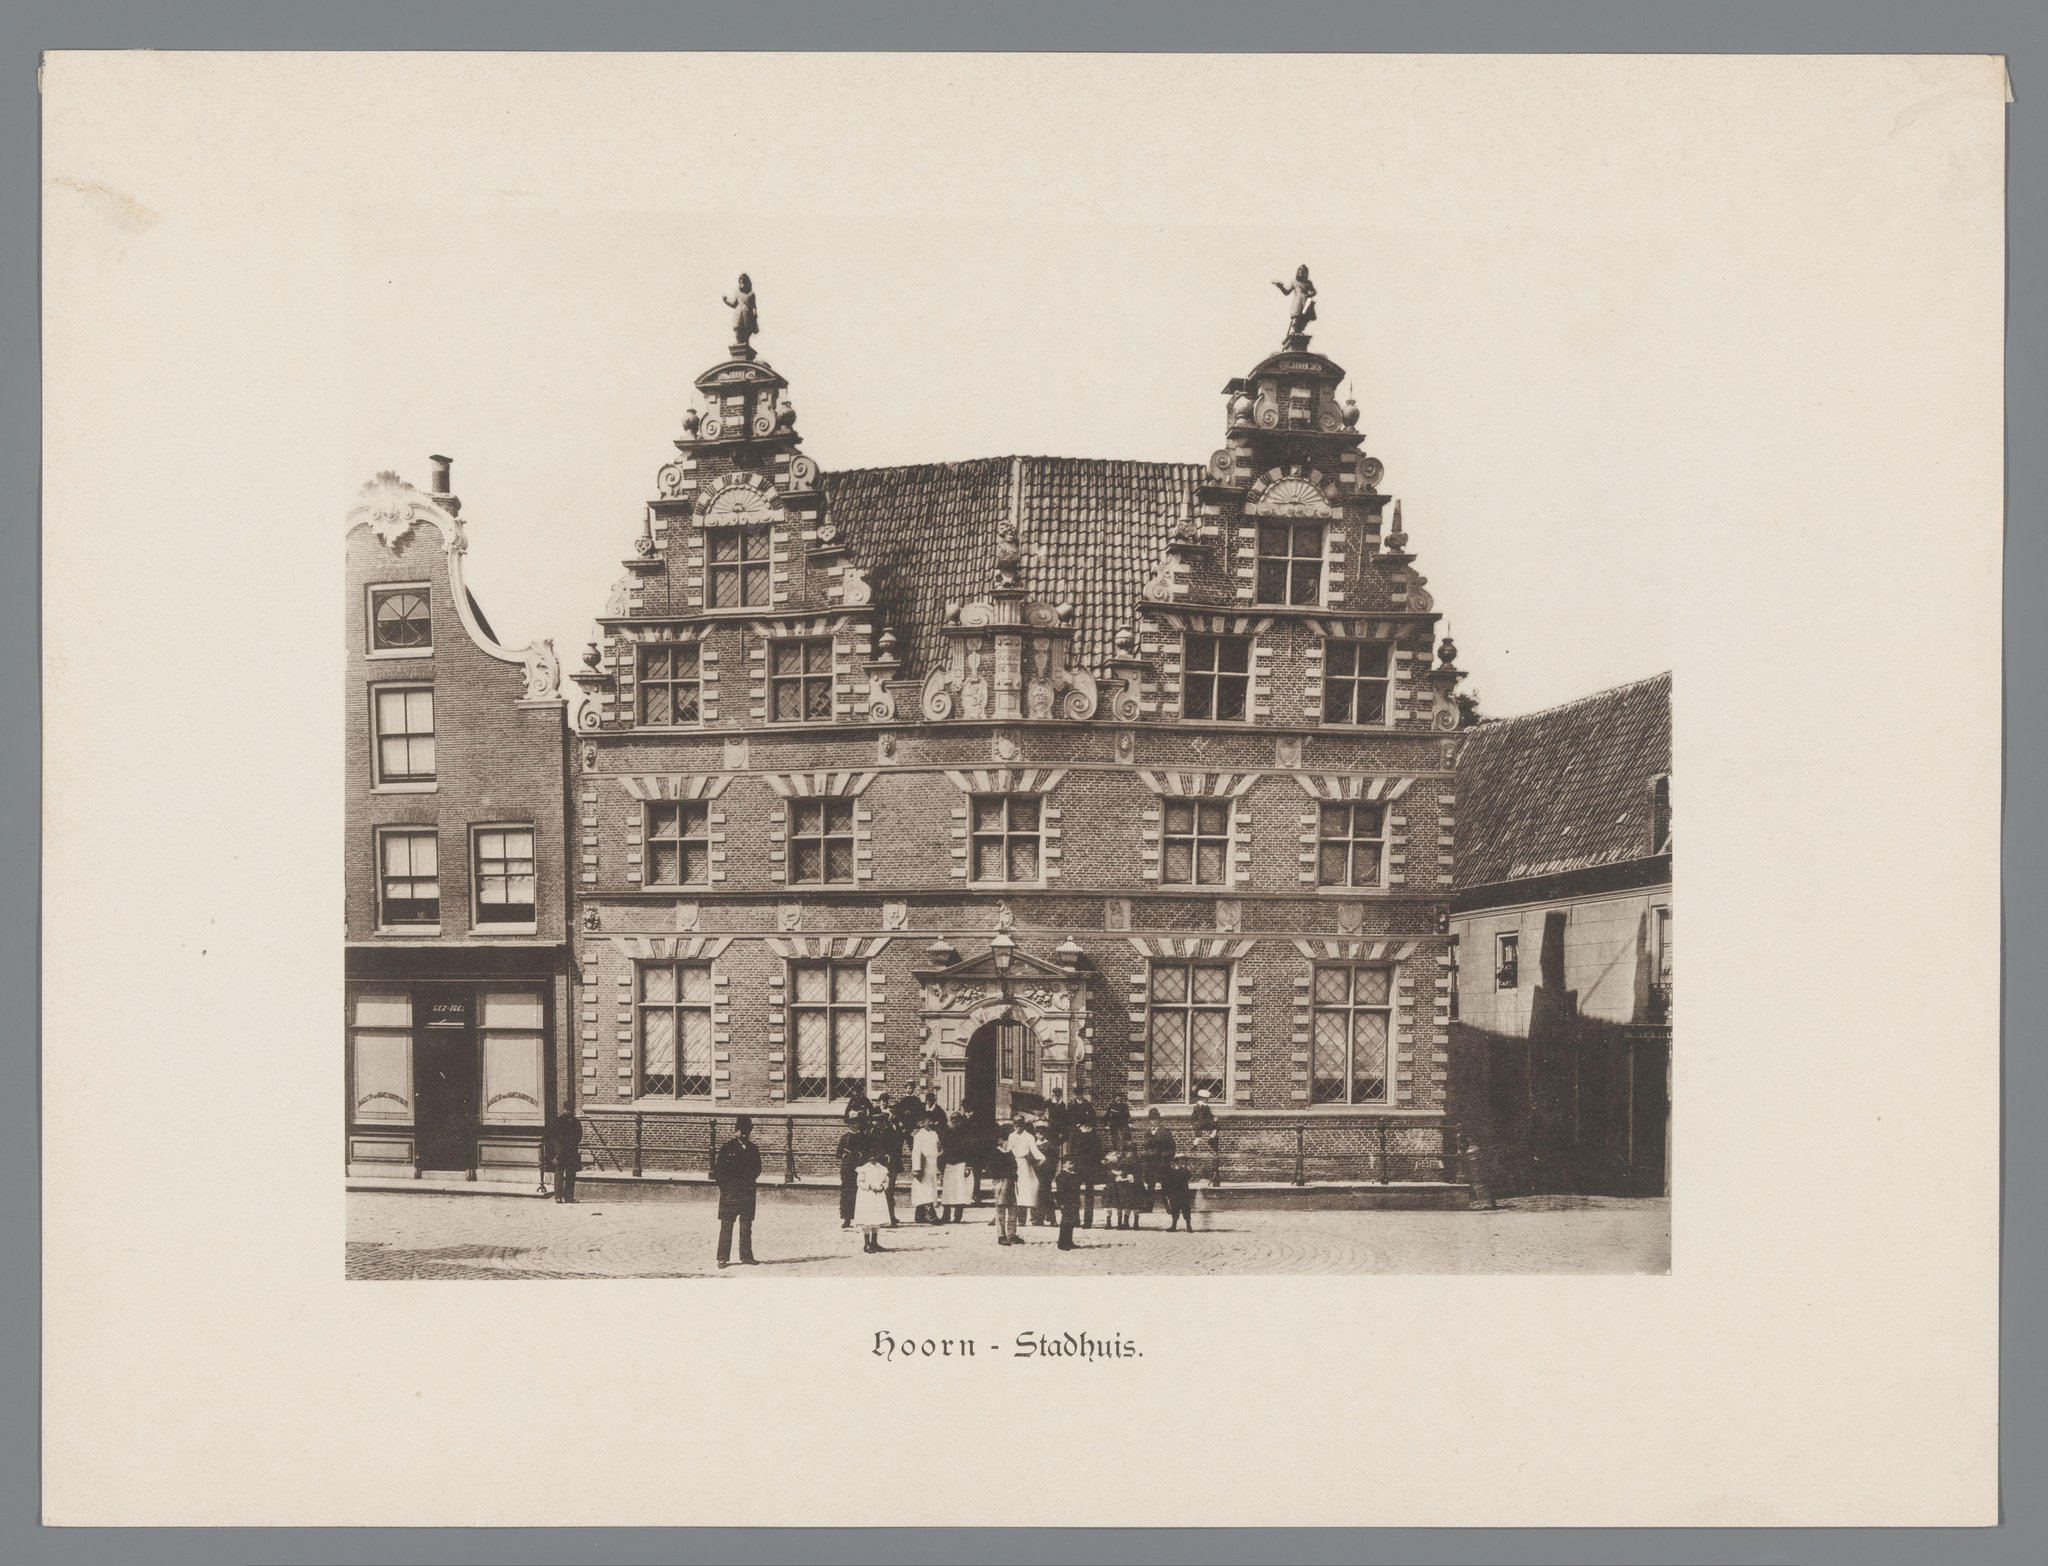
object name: photomechanical print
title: Gezicht op het stadhuis van Hoorn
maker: Anonymous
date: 1850-1950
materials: paper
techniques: photograph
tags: townhall, hoorn (north holland)